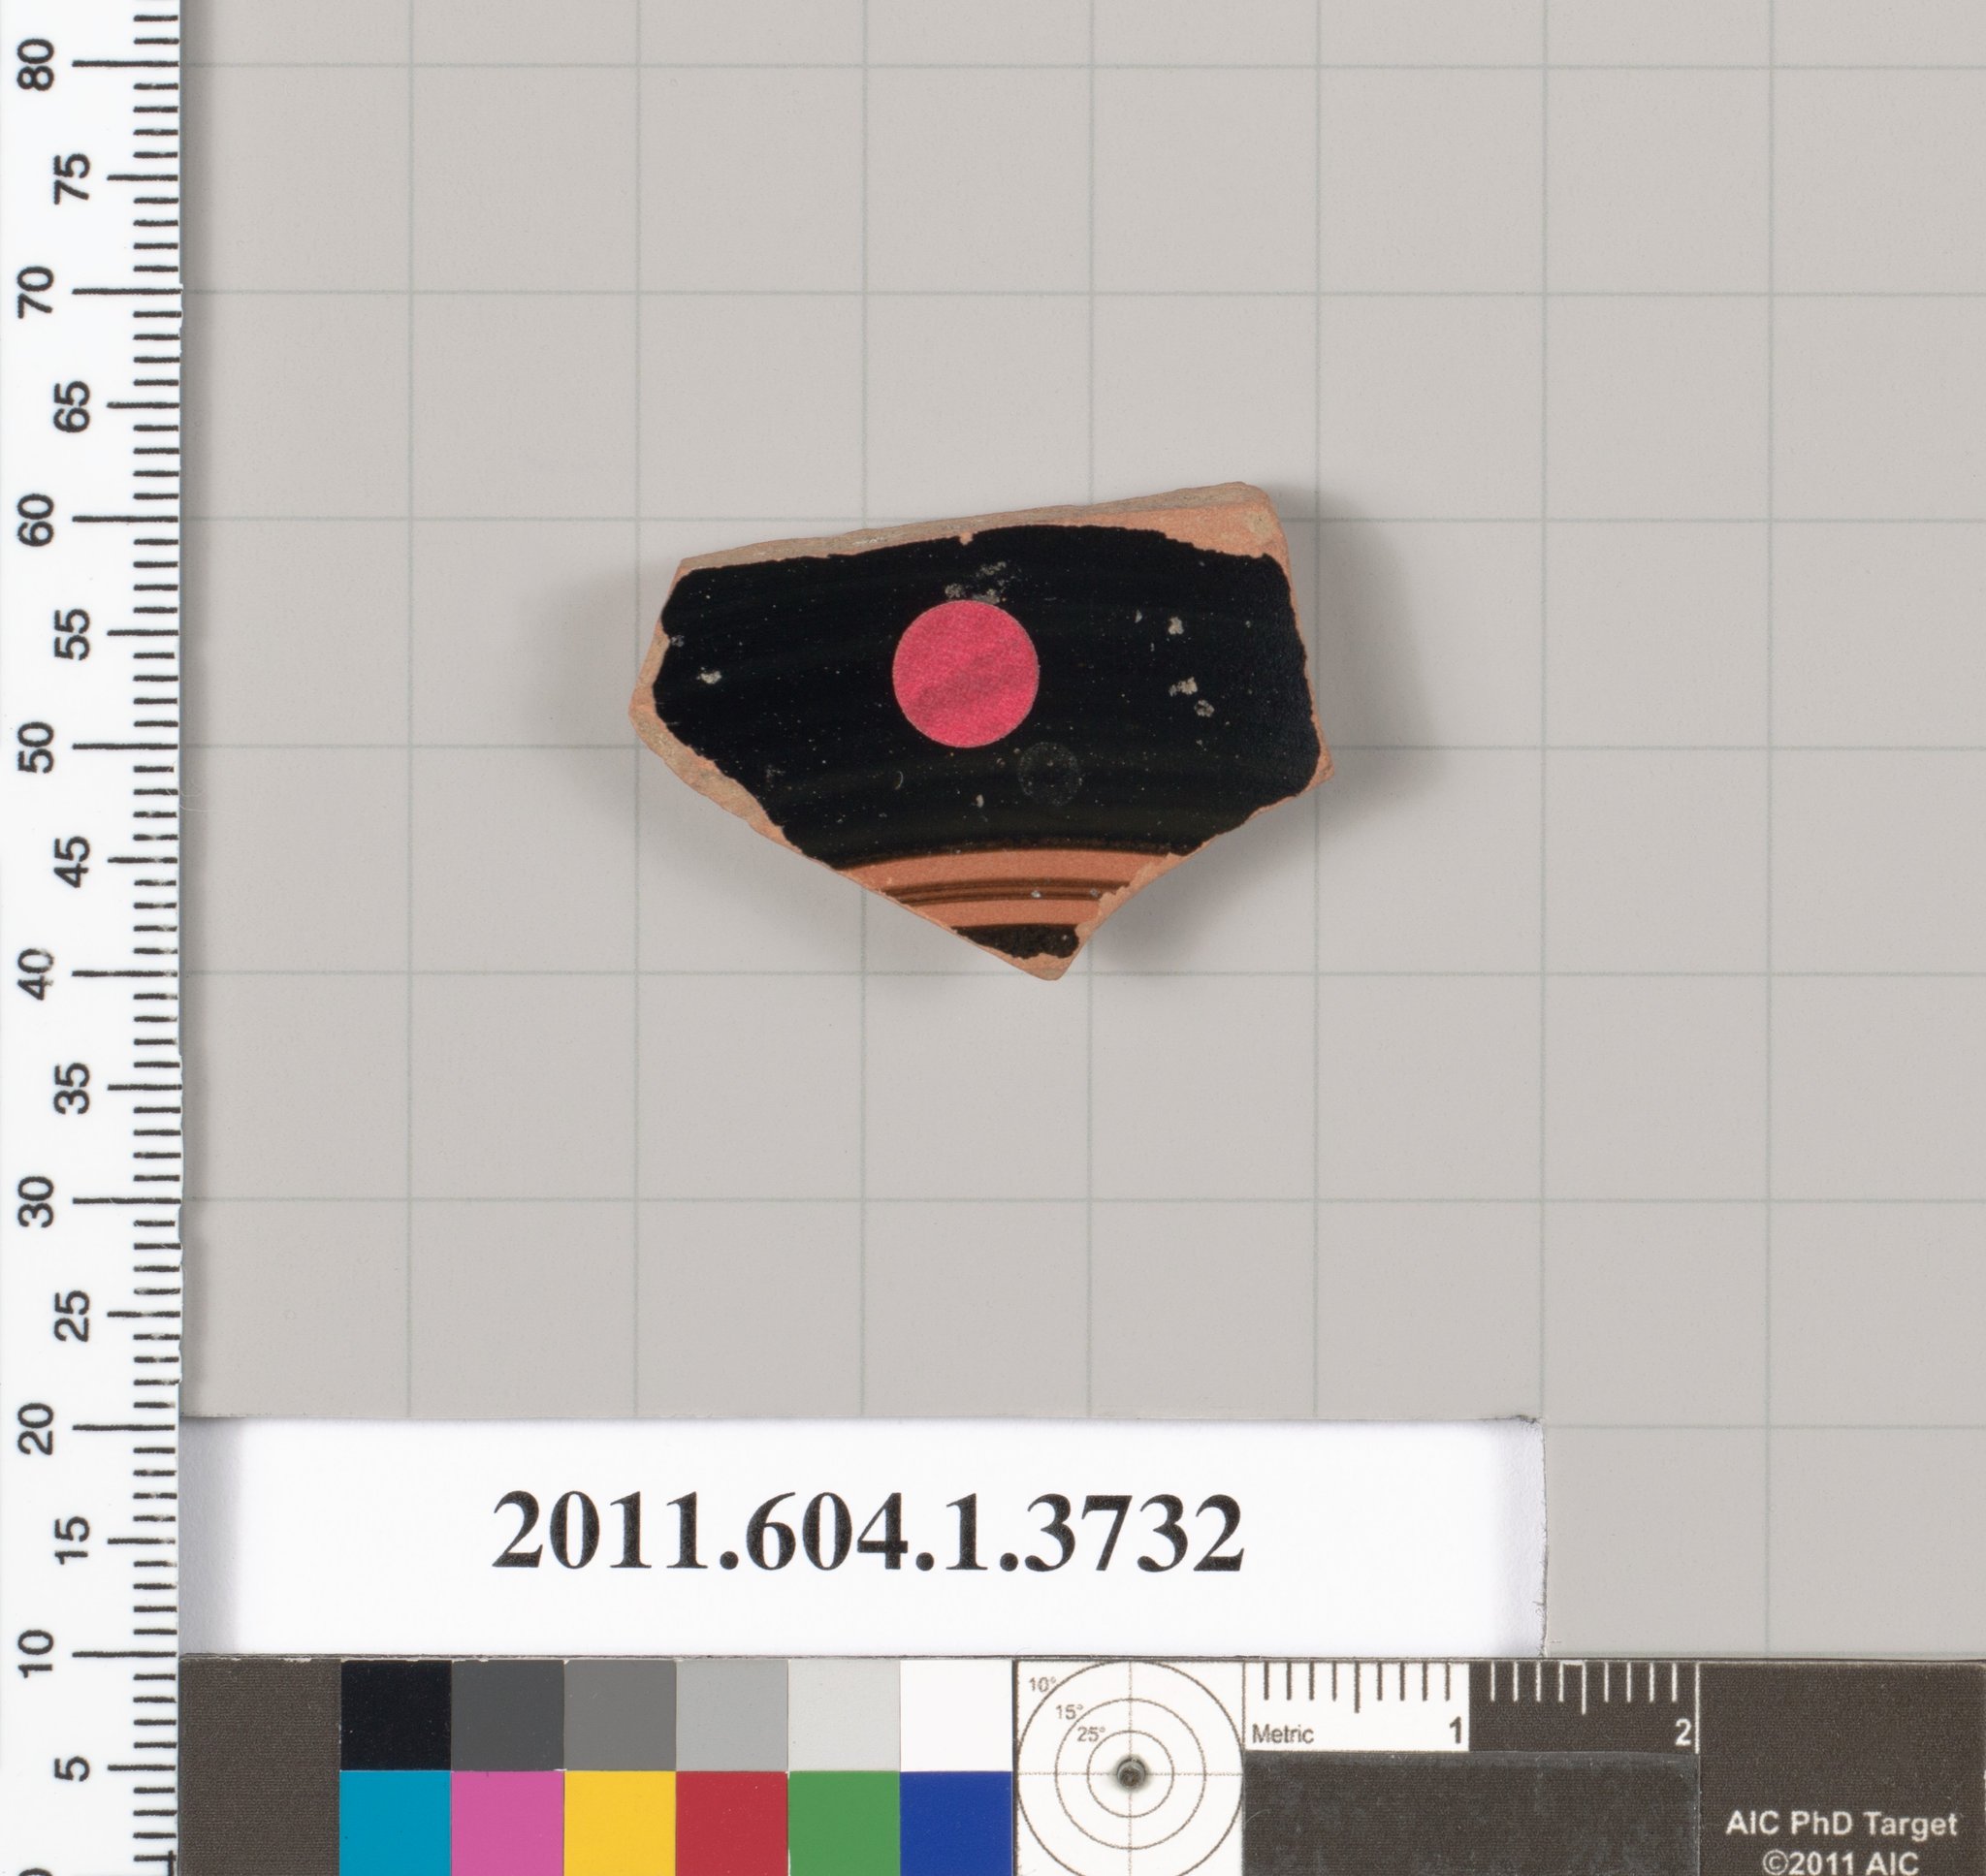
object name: kylix fragment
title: Terracotta fragment of a kylix (drinking cup)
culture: greek, attic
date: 475-451 BCE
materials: terracotta